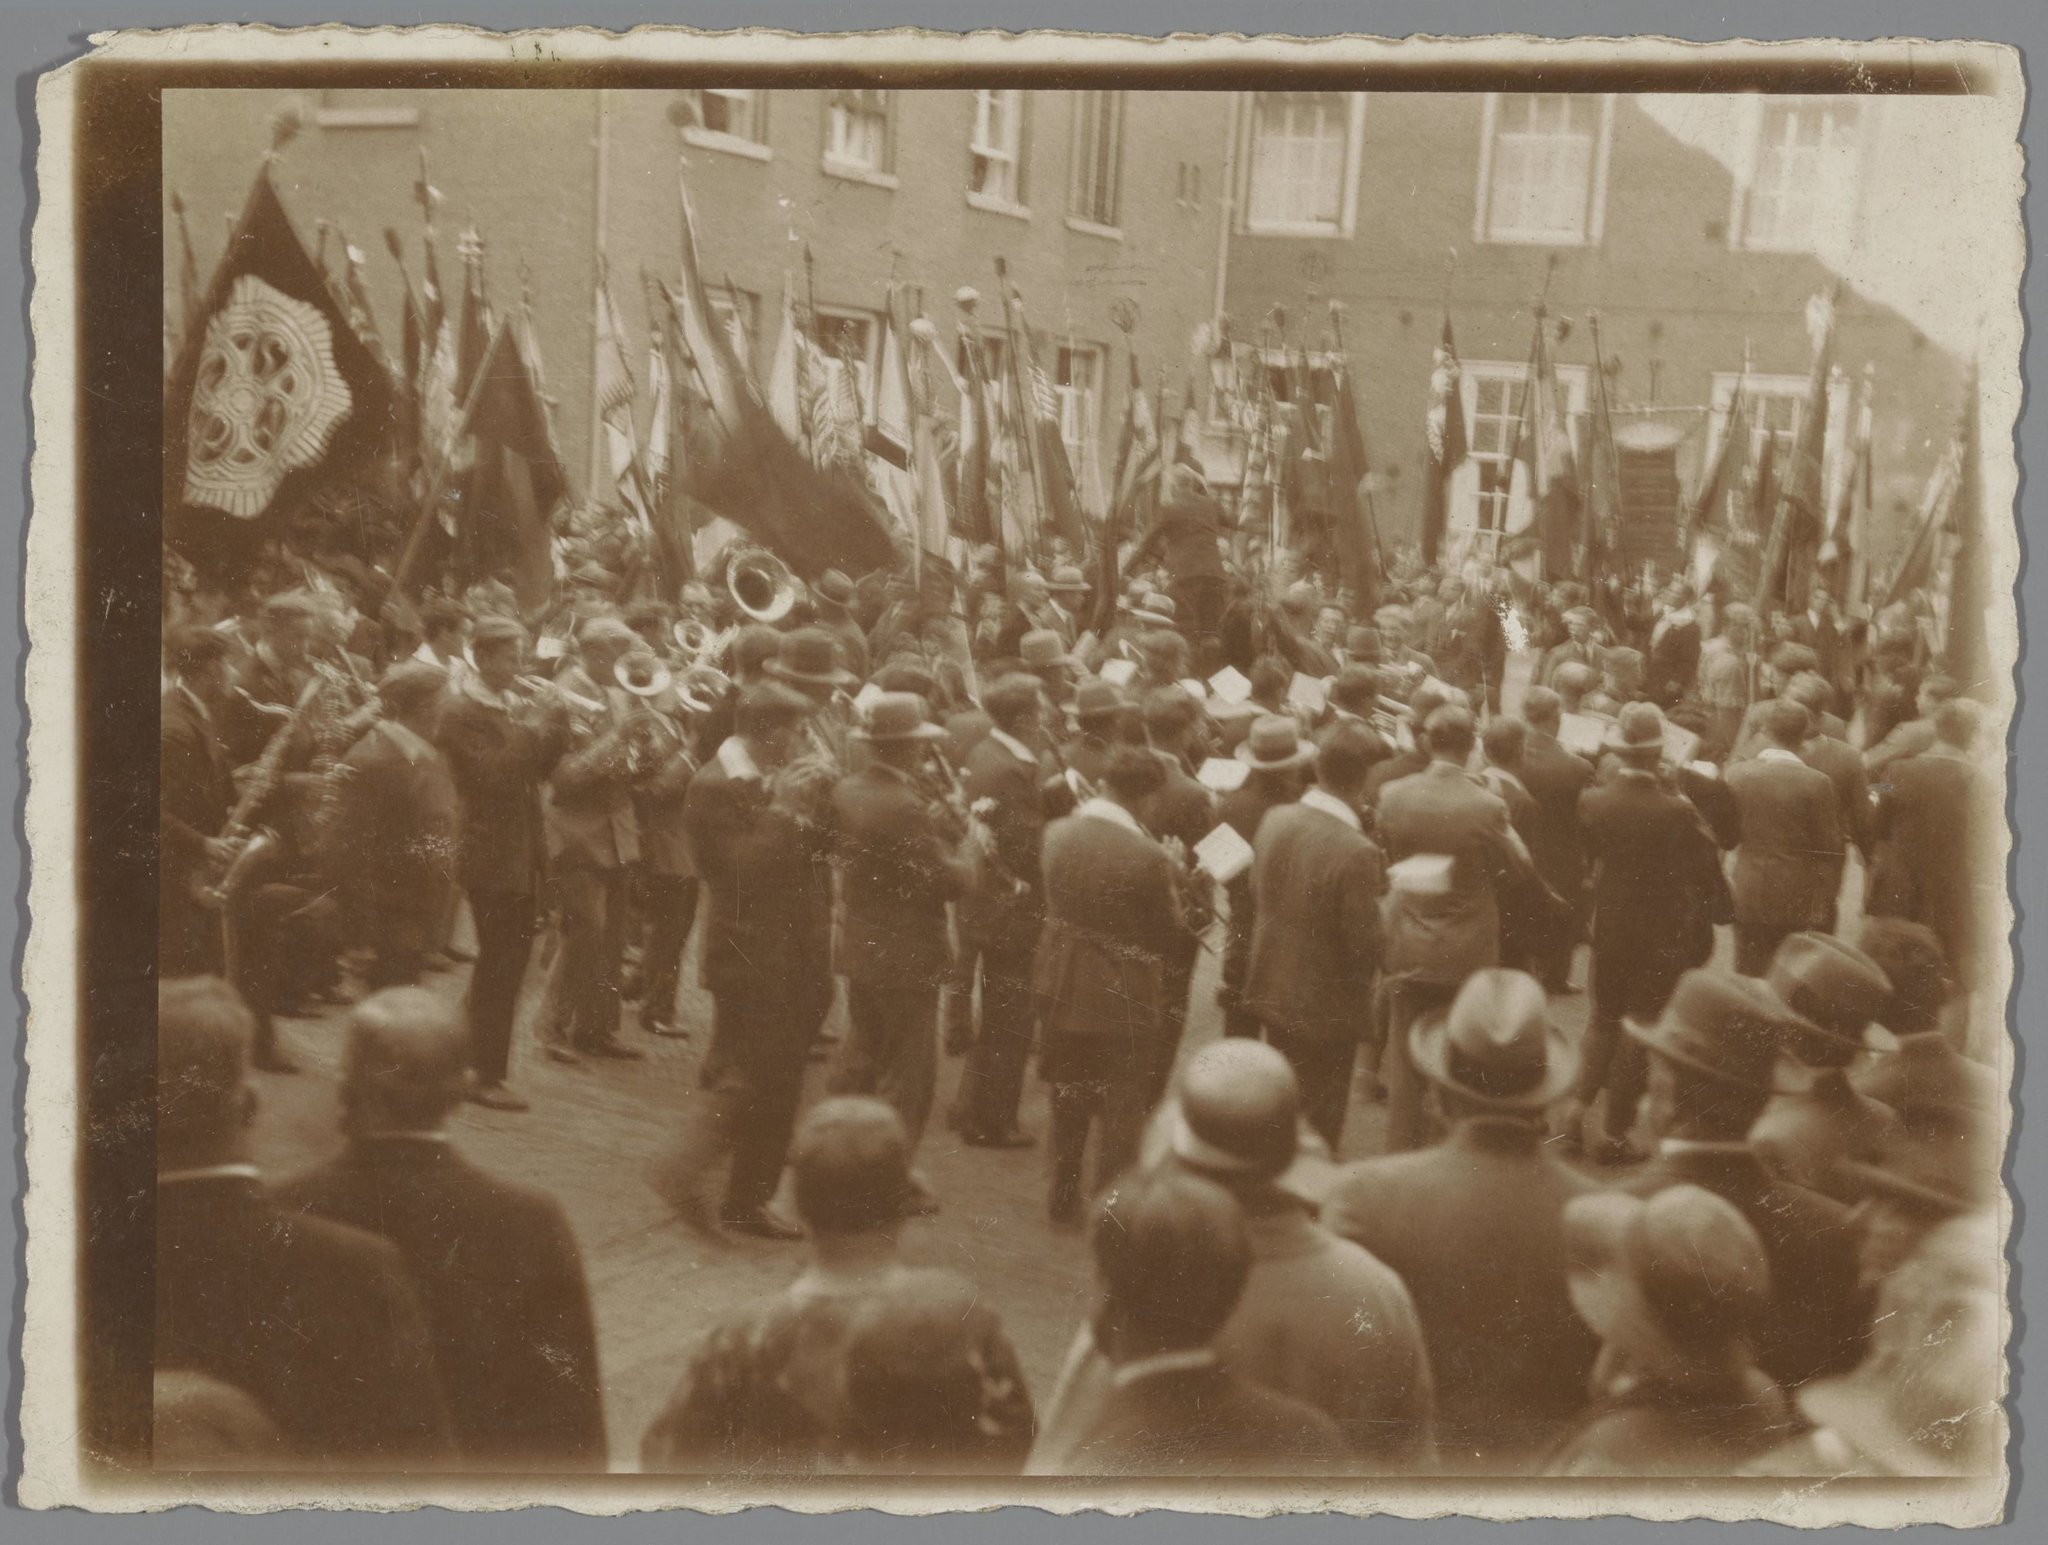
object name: photograph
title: Optocht van muziekvereniging 'Kunst en strijd' uit Amsterdam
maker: Anonymous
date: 1930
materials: photographic support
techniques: gelatin silver print